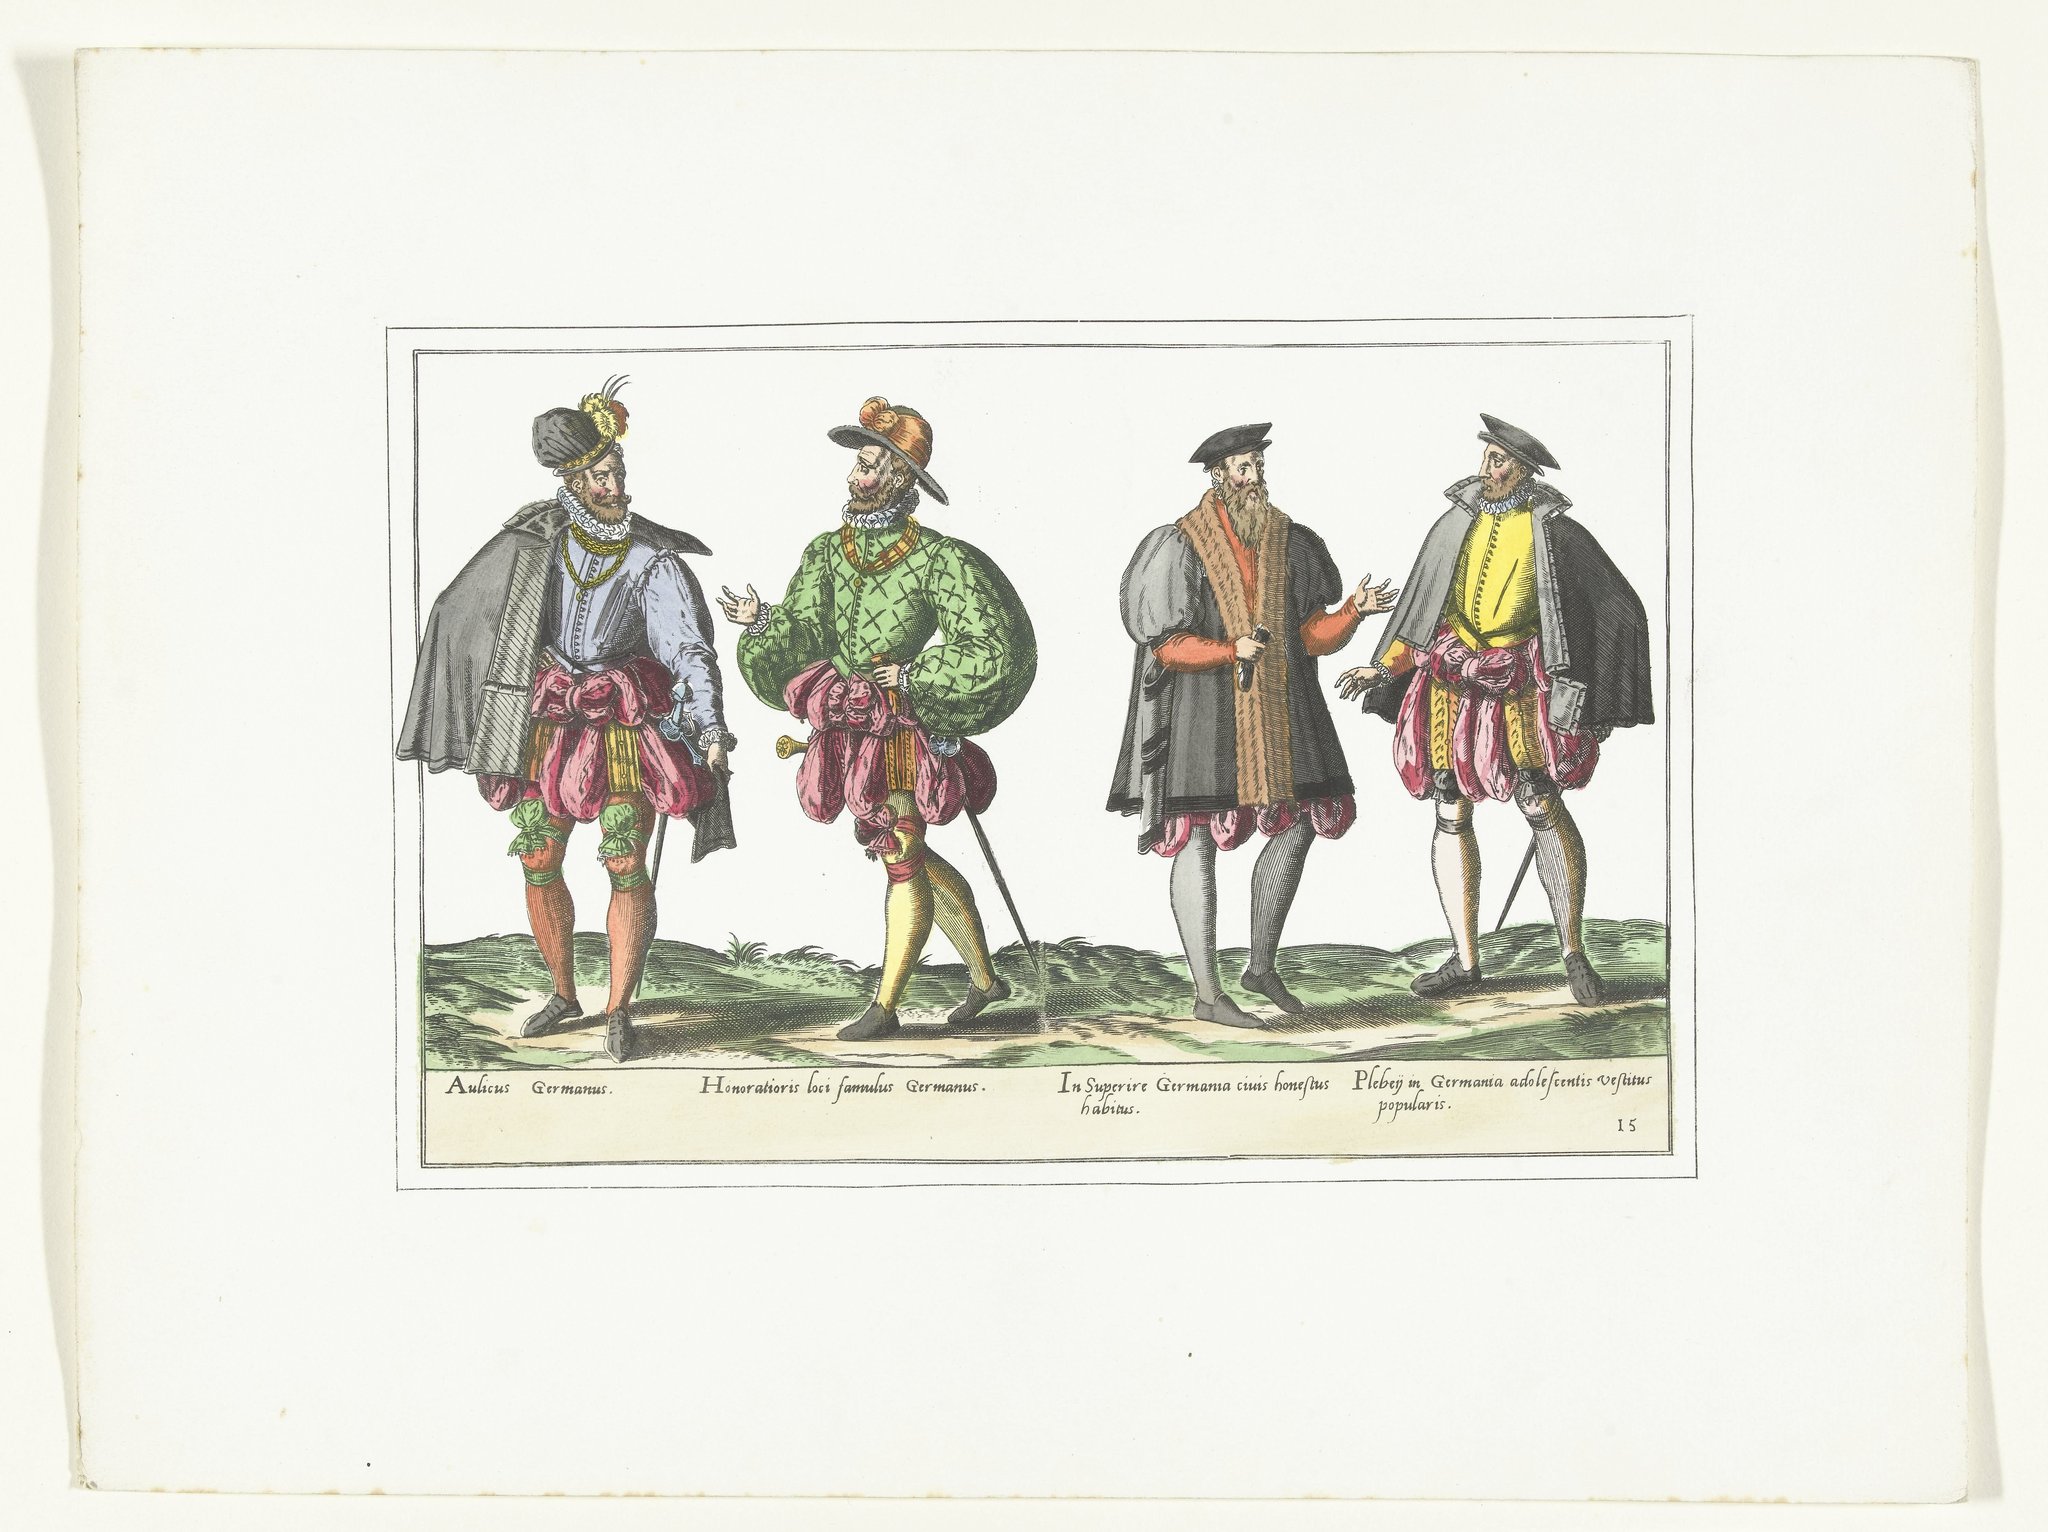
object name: print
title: Vier mannen gekleed volgens de Duitse mode, ca. 1580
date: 1872-1875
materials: paper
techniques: hand coloring, printing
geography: belgium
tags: clothes, costume (+ men's clothes), germany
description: Onderdeel van Costumes civils et militaires du XVIe siècle par A. de Bruyn, een selectie van prenten uit de Trachtenbuch van Abraham de Bruyn uit 1581 (Hollstein 248-306), in facsimile. Losbladig uitgegeven met titelbladen, verklaring en lijst van de platen door G.A. van Trigt te Brussel in 1875 met teksten van Auguste Schoy. In de Rijksmuseum Research Library met signatuur 34 C 43.